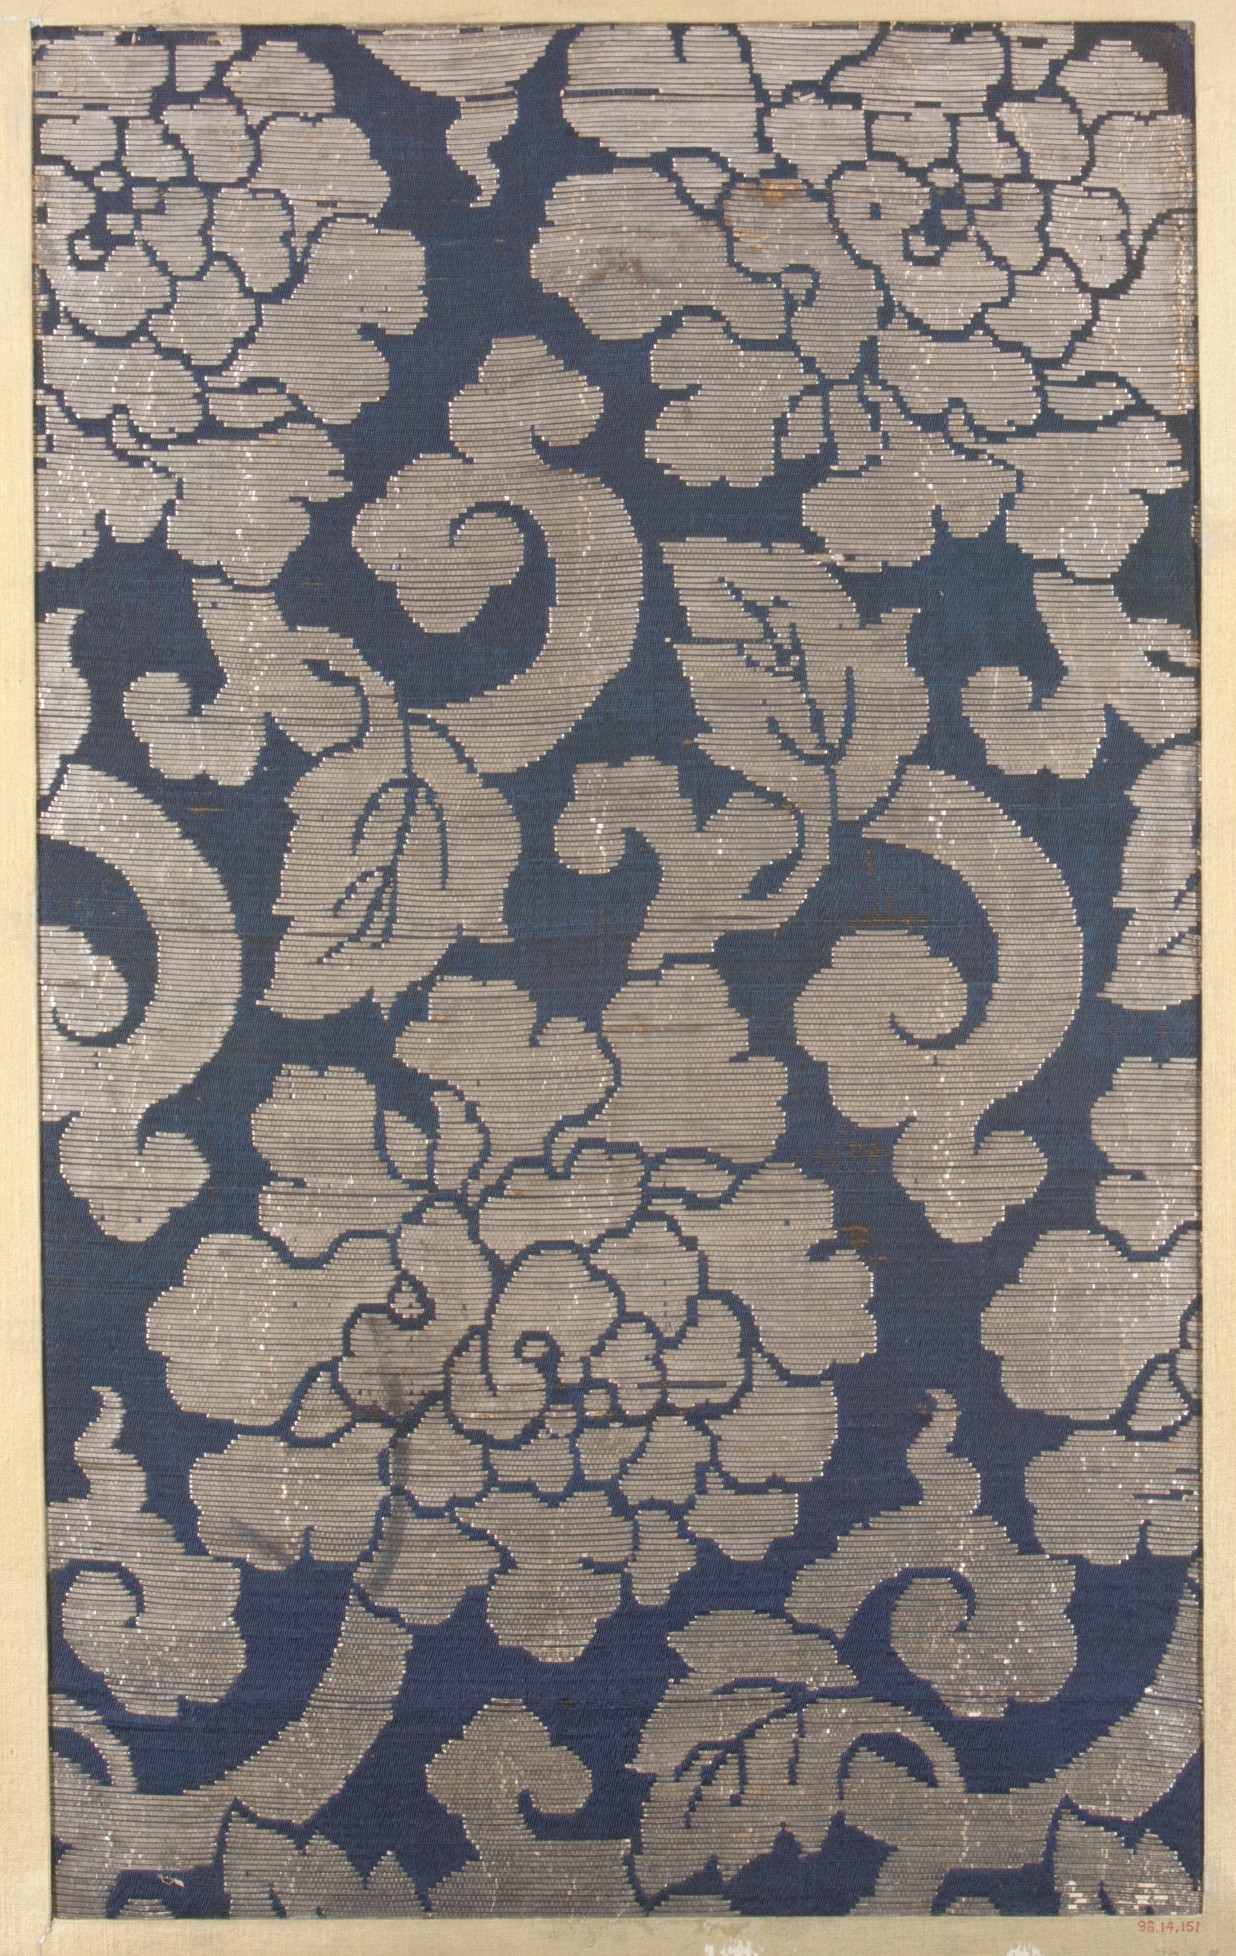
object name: piece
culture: chinese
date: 1701-1900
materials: silk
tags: leaves